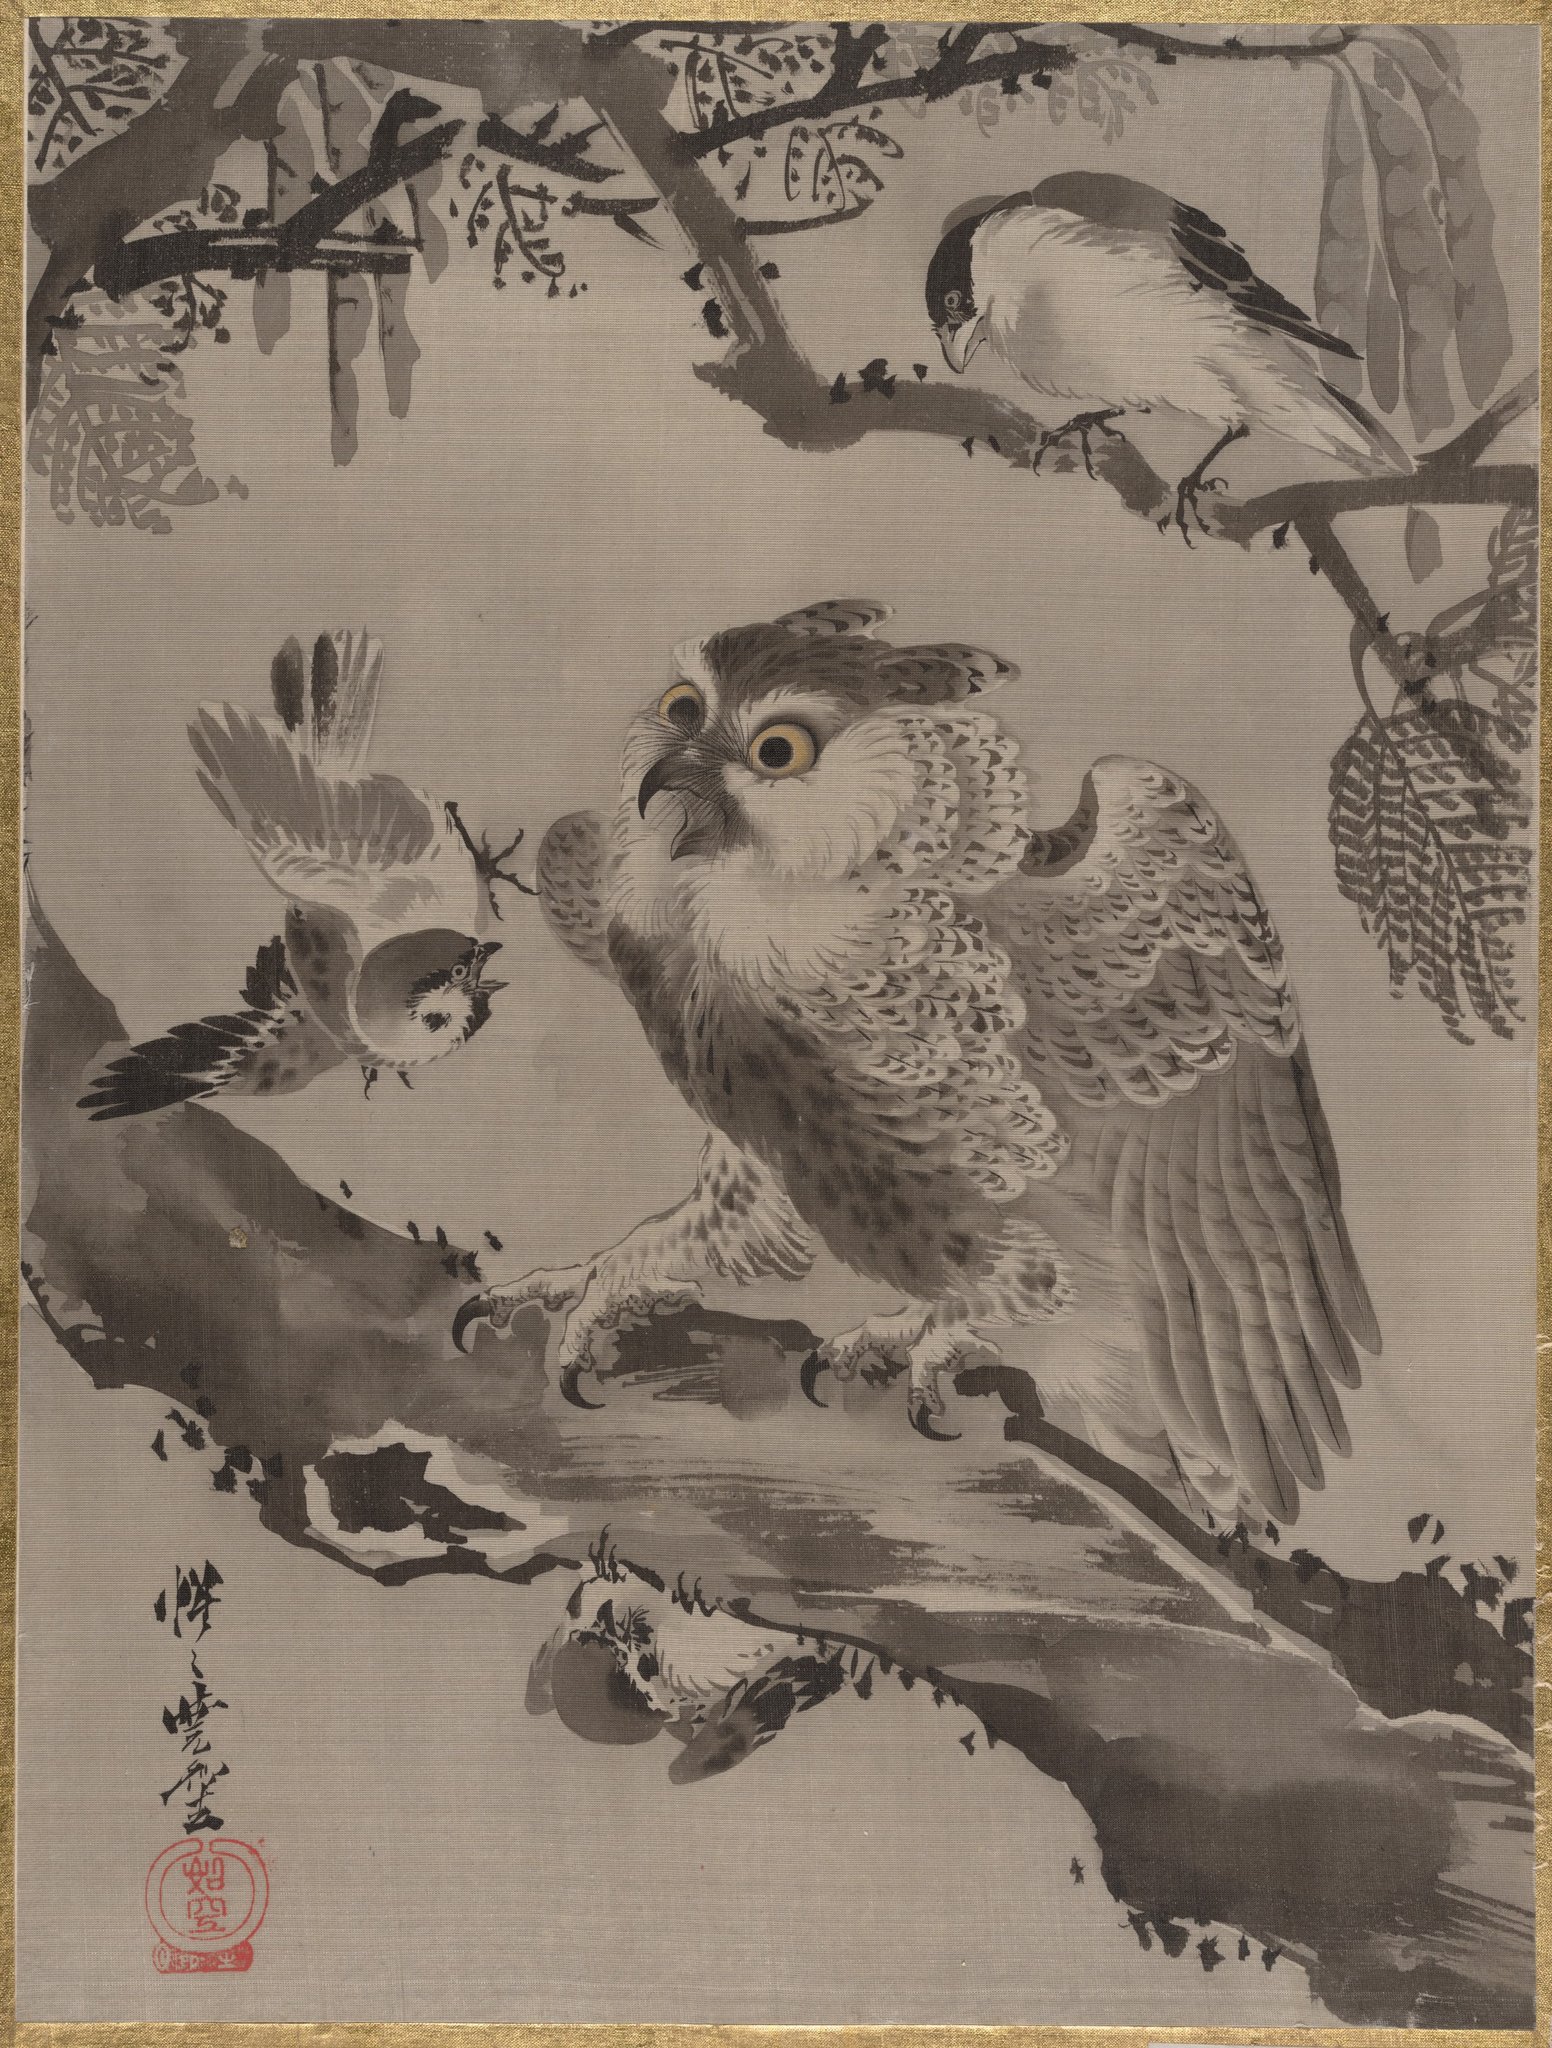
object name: album leaf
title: Owl Mocked by Small Birds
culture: japanese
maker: kawanabe kyōsai 河鍋暁斎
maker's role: artist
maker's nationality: japanese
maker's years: 1831-1889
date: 1887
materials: ink, silk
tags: birds,owls